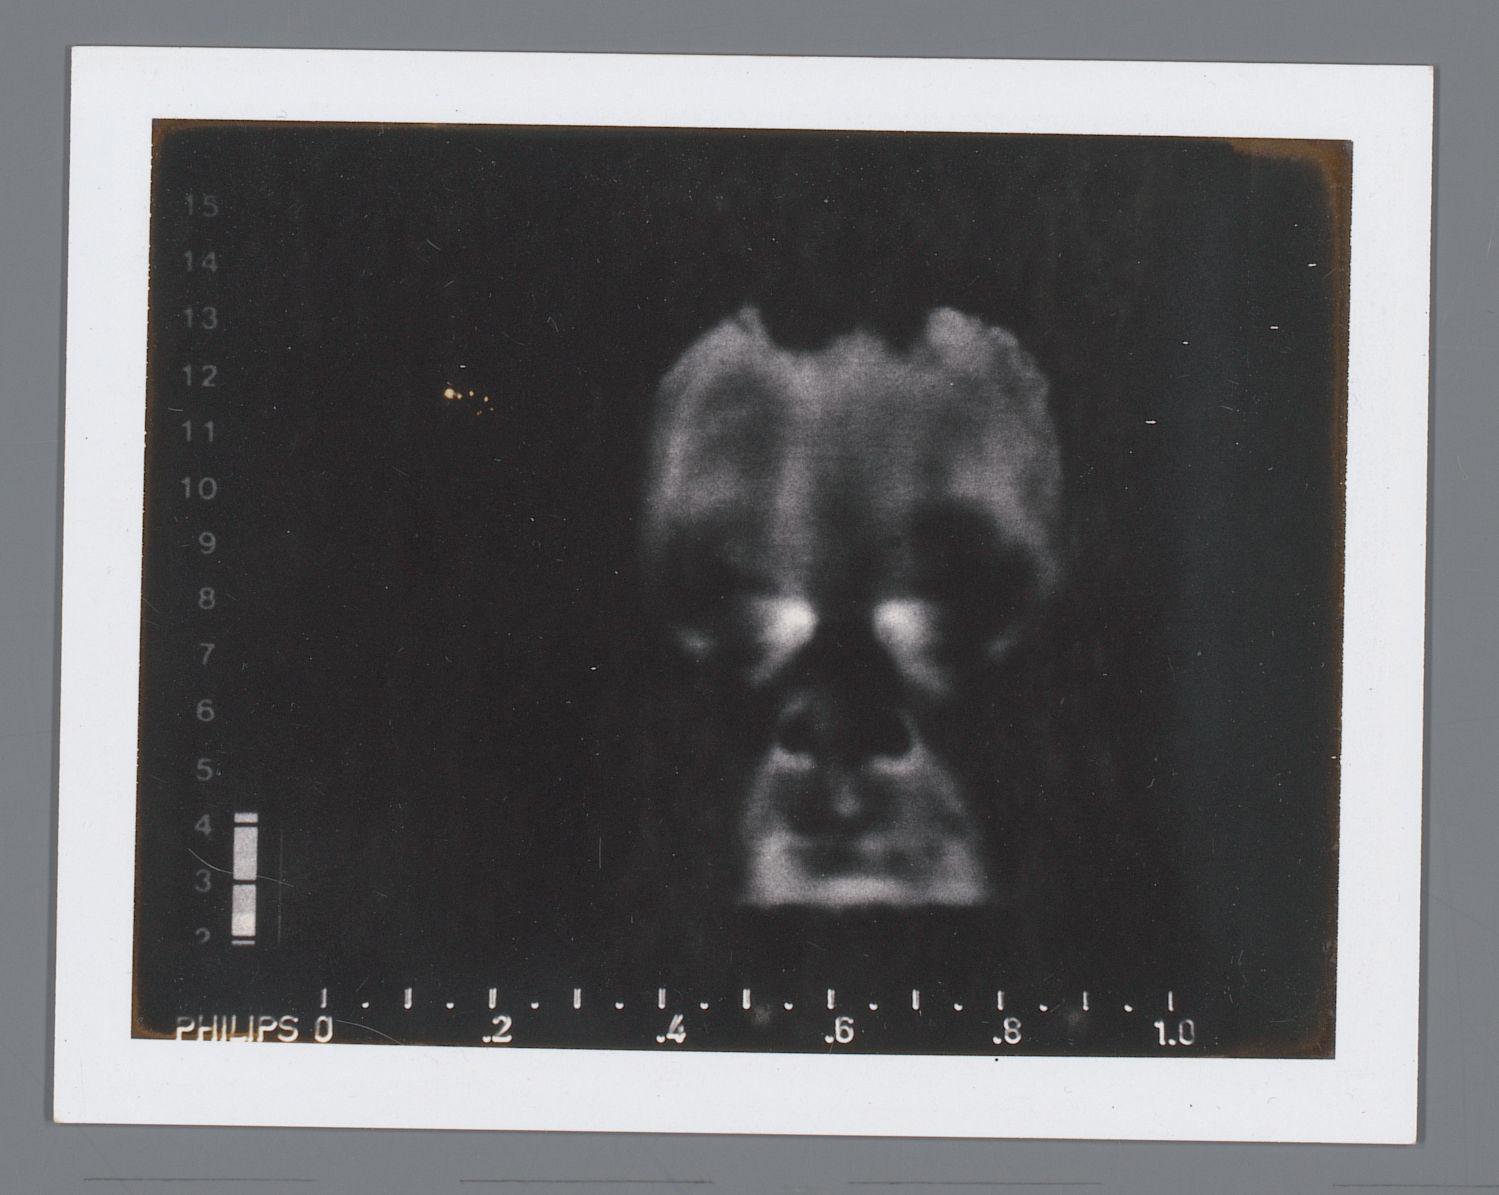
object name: instant photograph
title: Thermogram van een menselijk hoofd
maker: Anonymous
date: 1950-1984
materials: paper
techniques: dye diffusion transfer print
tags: head (human)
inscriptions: number: ‘F86X801’, inscription: ‘Einhorn’